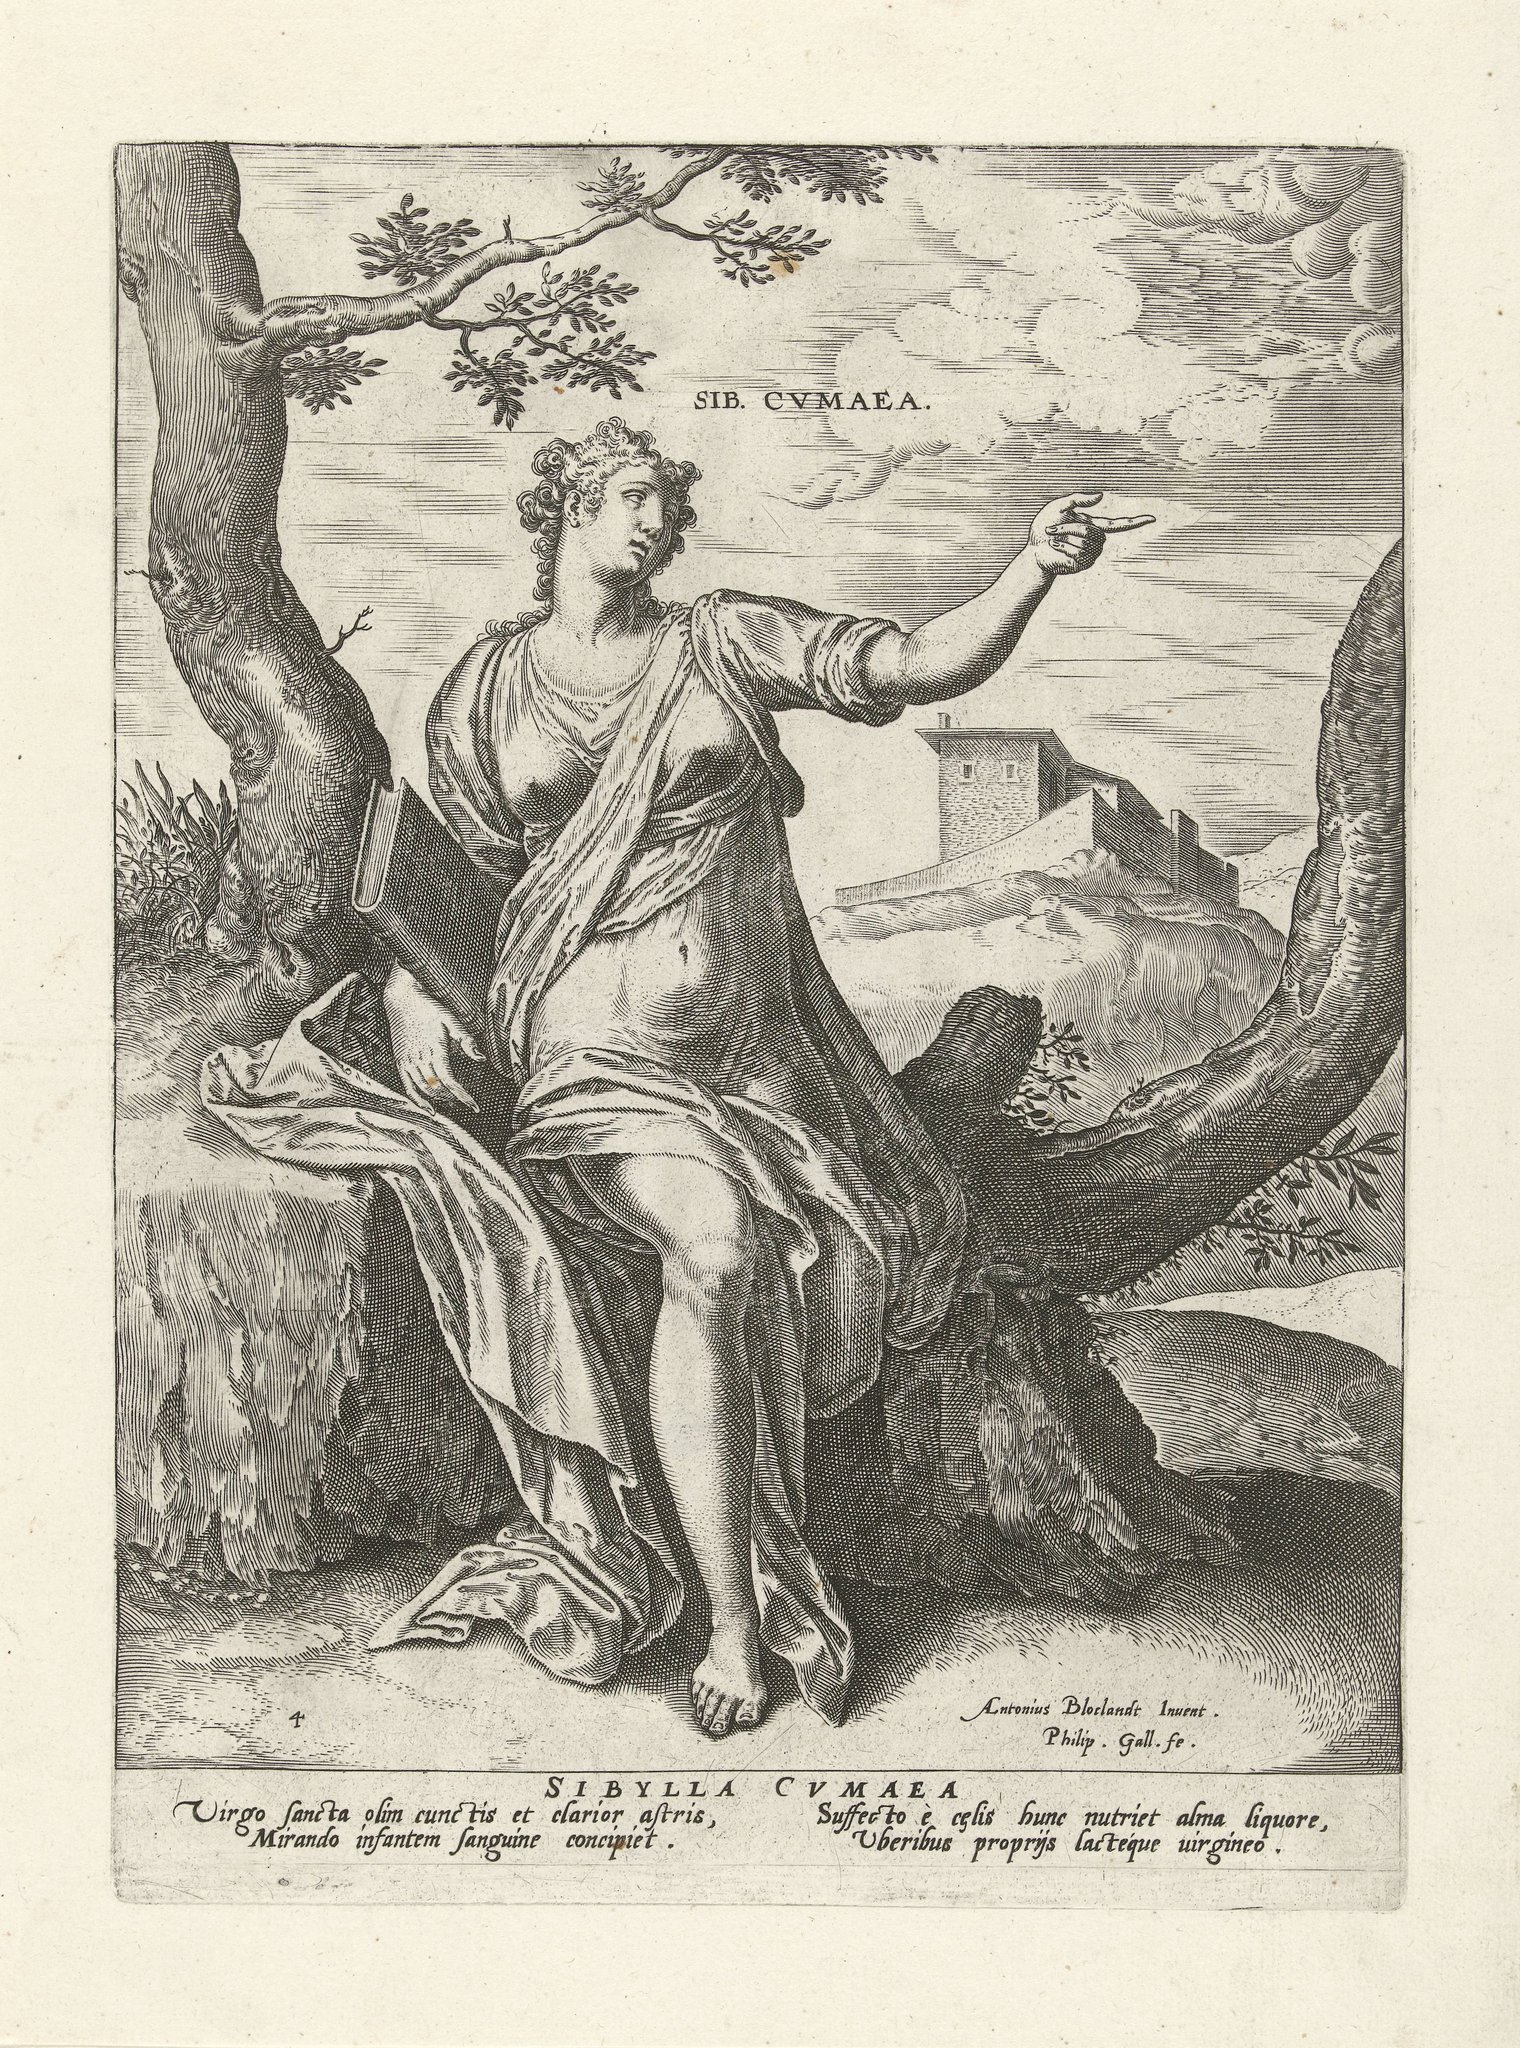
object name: print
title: Sibillen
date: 1575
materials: paper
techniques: engraving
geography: antwerp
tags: cumaean sibyl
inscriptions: collector's mark: Lugt 2228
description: De Sibille van Cumae zit op een boomstronk. Ze heeft een boek vast. De prent heeft een Latijns onderschrift en maakt deel uit van een tiendelige serie over de Sibillen.